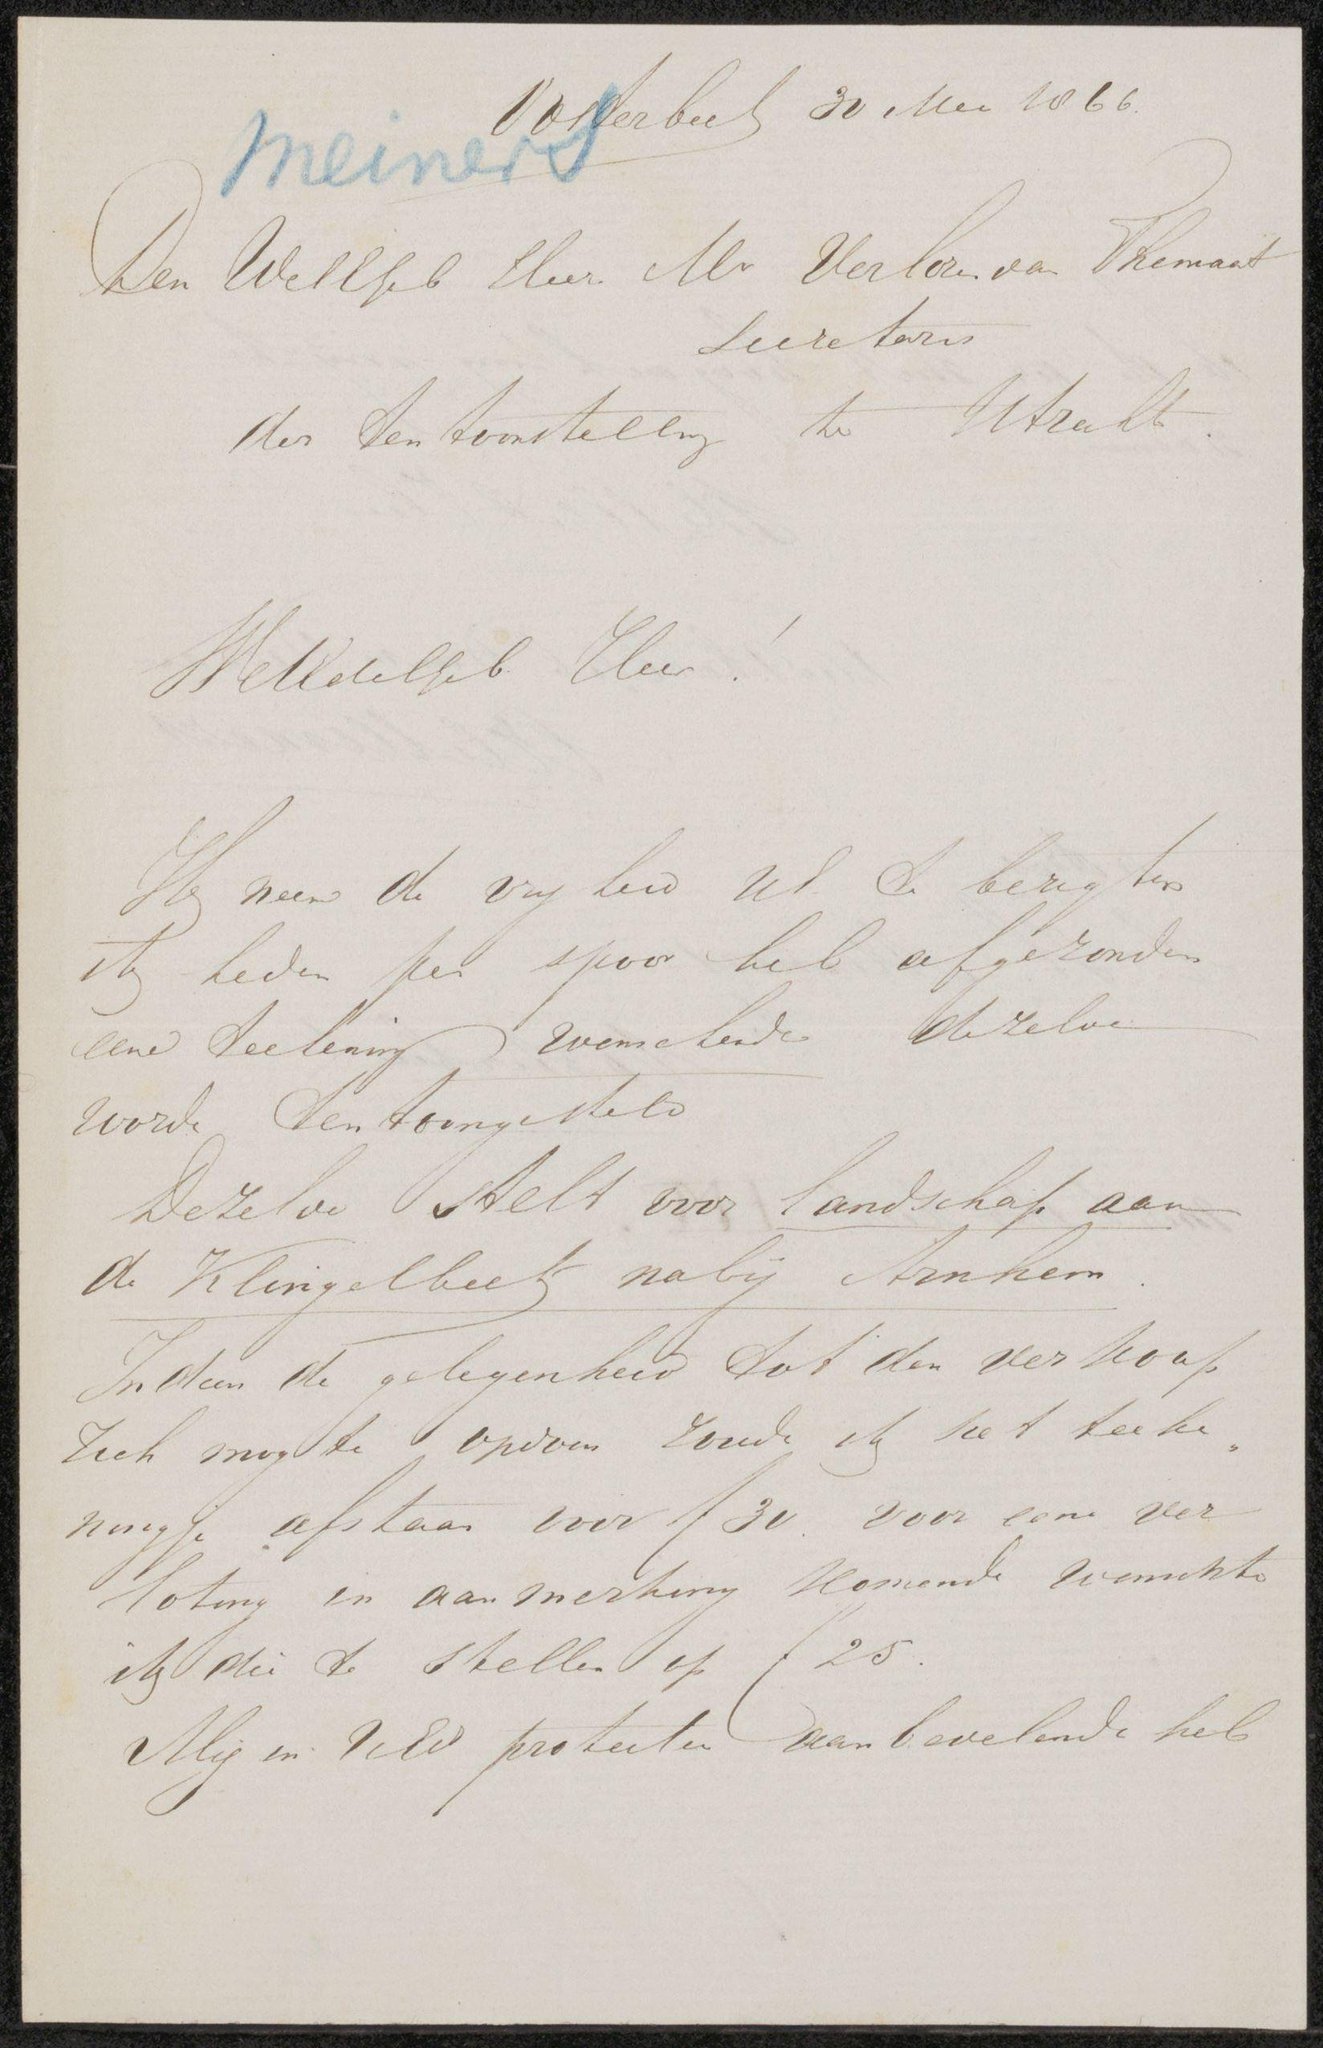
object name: letter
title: Brief aan Pieter Verloren van Themaat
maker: claas hendrik meiners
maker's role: painter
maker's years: 1819-1894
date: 1866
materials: ink, paper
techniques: pen, writing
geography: oosterbeek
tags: pieter verloren van themaat, drawing, exhibition ~ art, money, utrecht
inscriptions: collector's mark: ‘RPK’